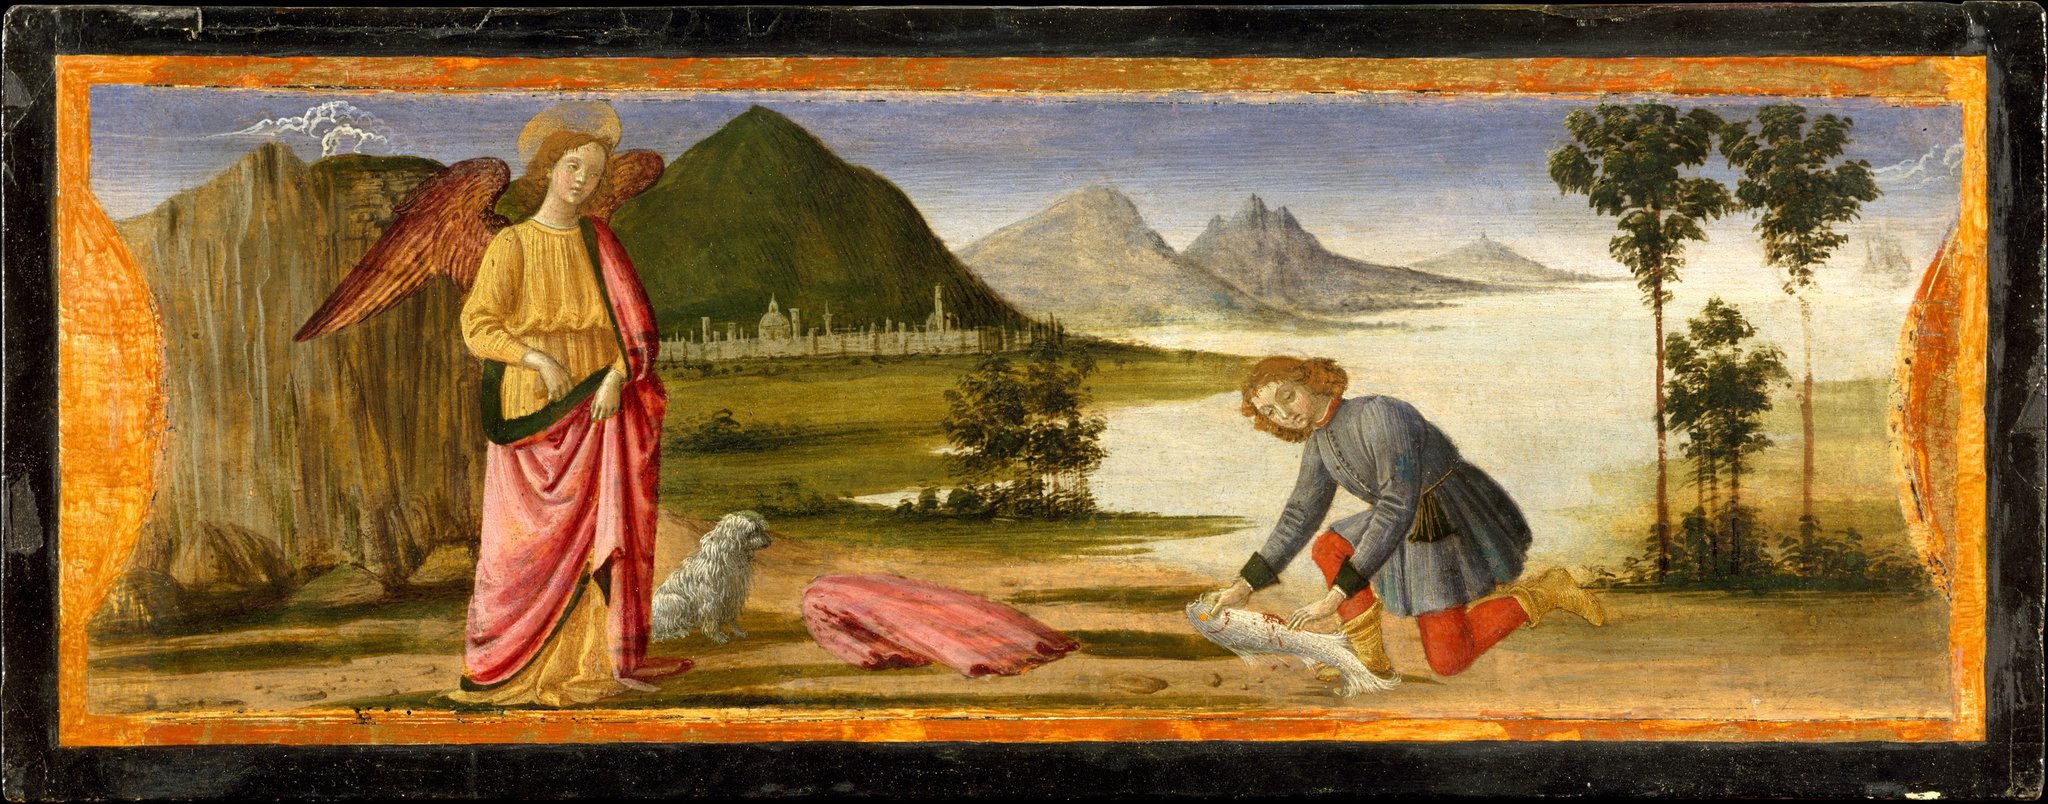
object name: painting, predella panel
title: Tobias and the Angel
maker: davide ghirlandaio (david bigordi)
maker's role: artist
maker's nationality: italian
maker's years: 1452-1525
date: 1479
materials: gold, paint, wood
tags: men,dogs,fish,angels